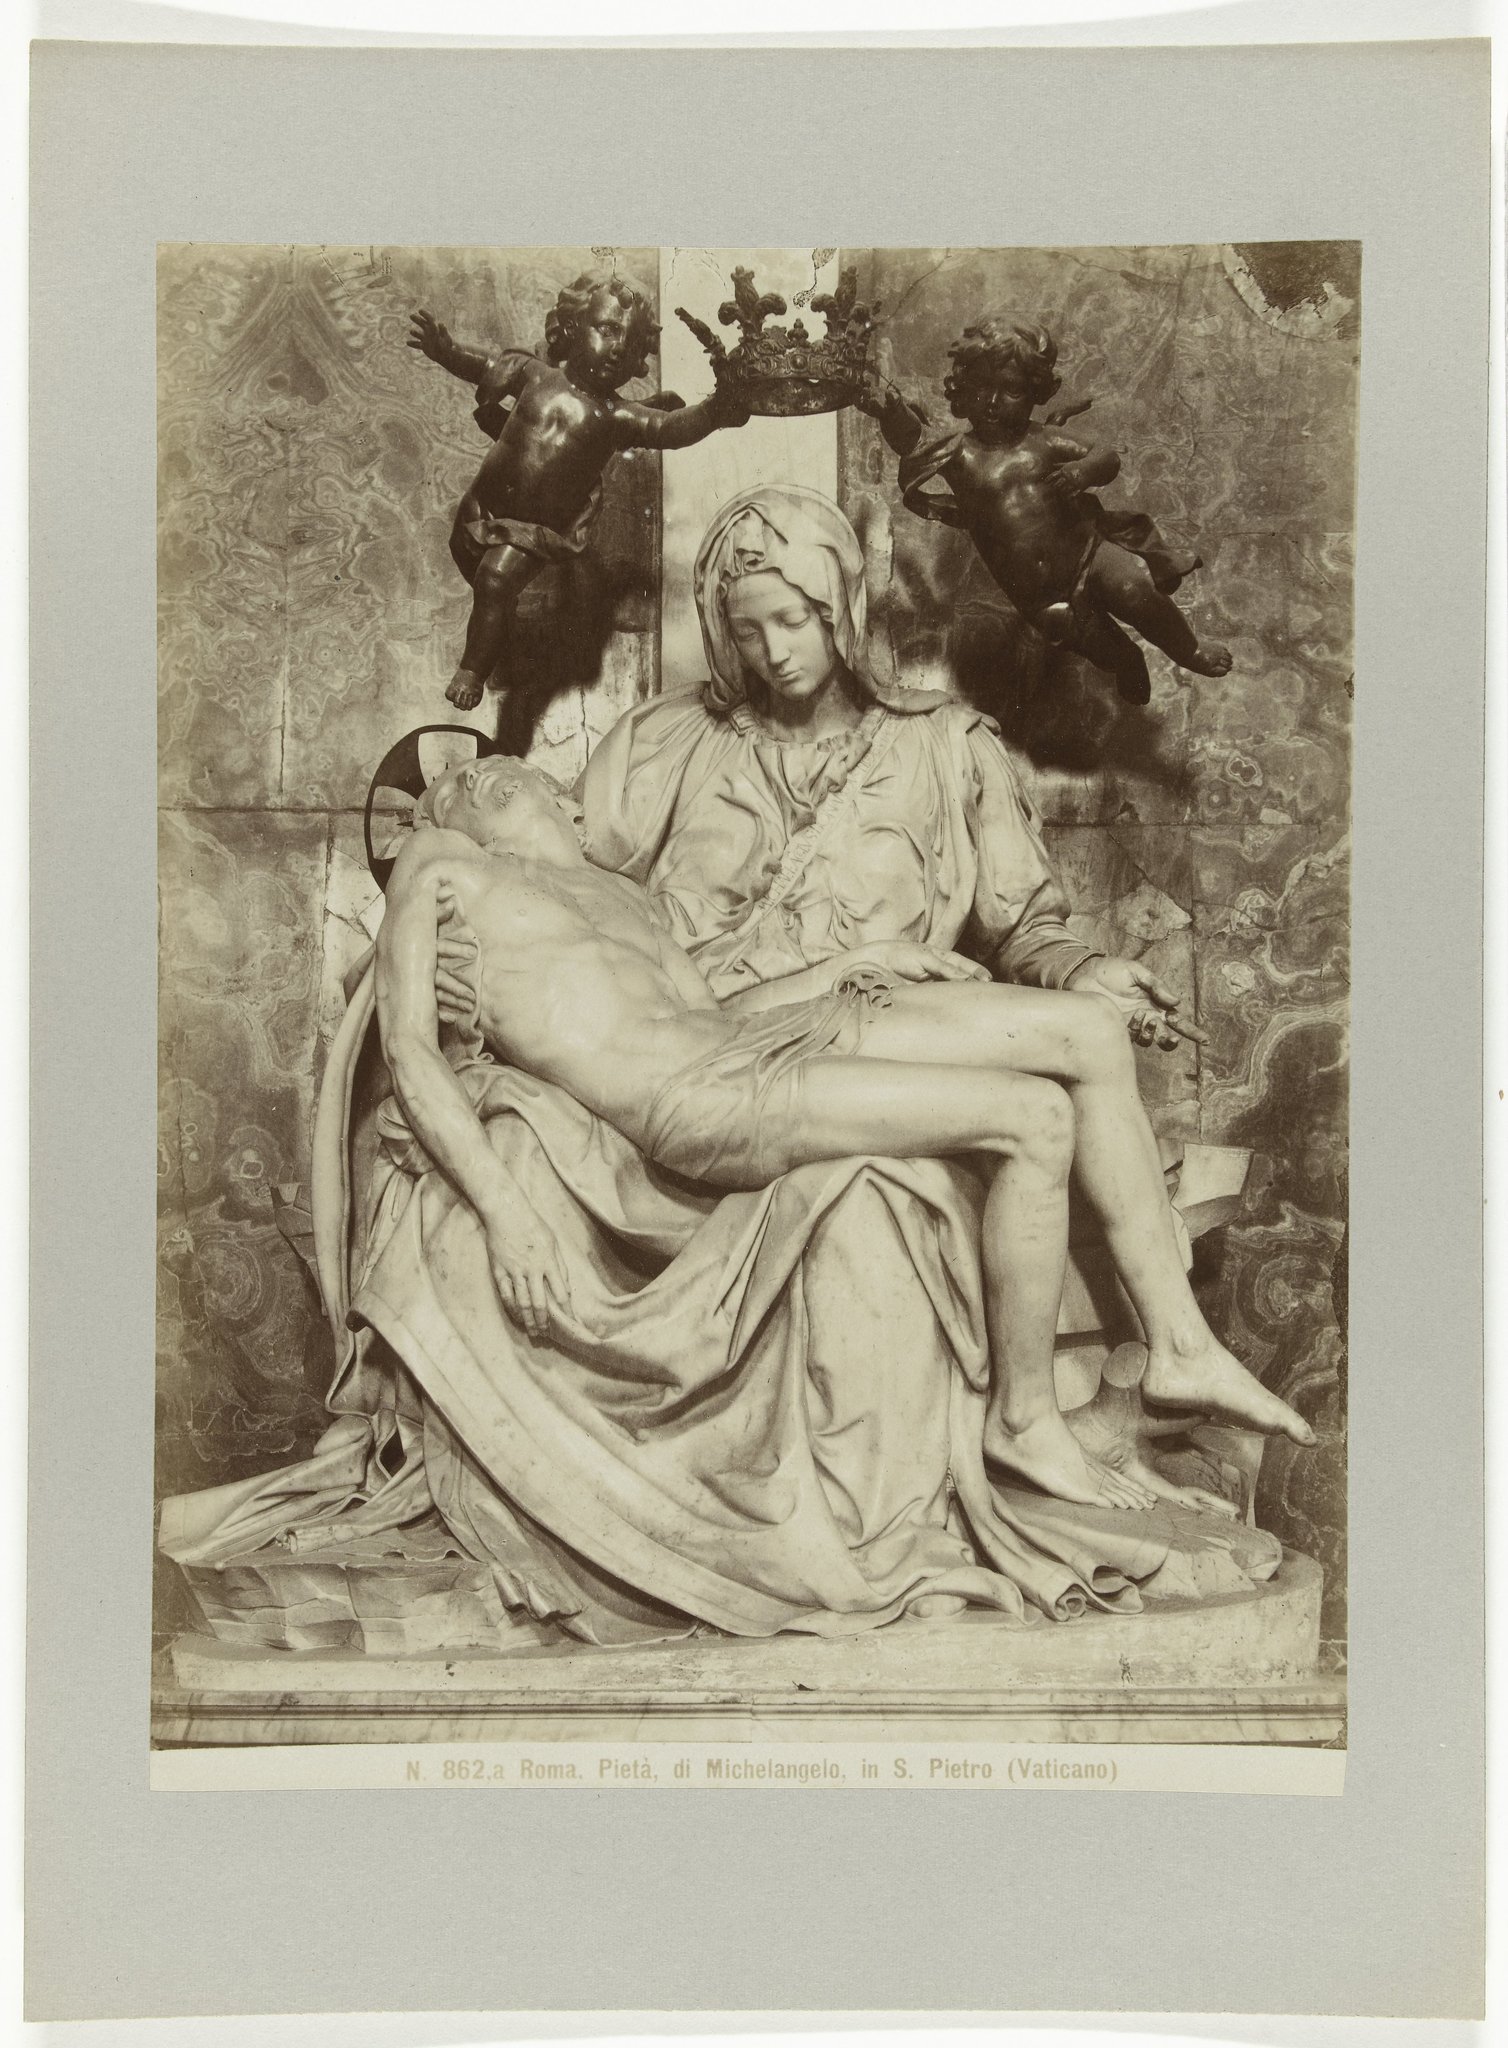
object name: photograph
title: Gebeeldhouwde piëta in de Sint-Pieter, Rome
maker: Anonymous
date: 1880-1904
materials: cardboard, paper, photographic support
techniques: albumen print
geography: rome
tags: sint-pietersbasiliek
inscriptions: number: ‘41.’